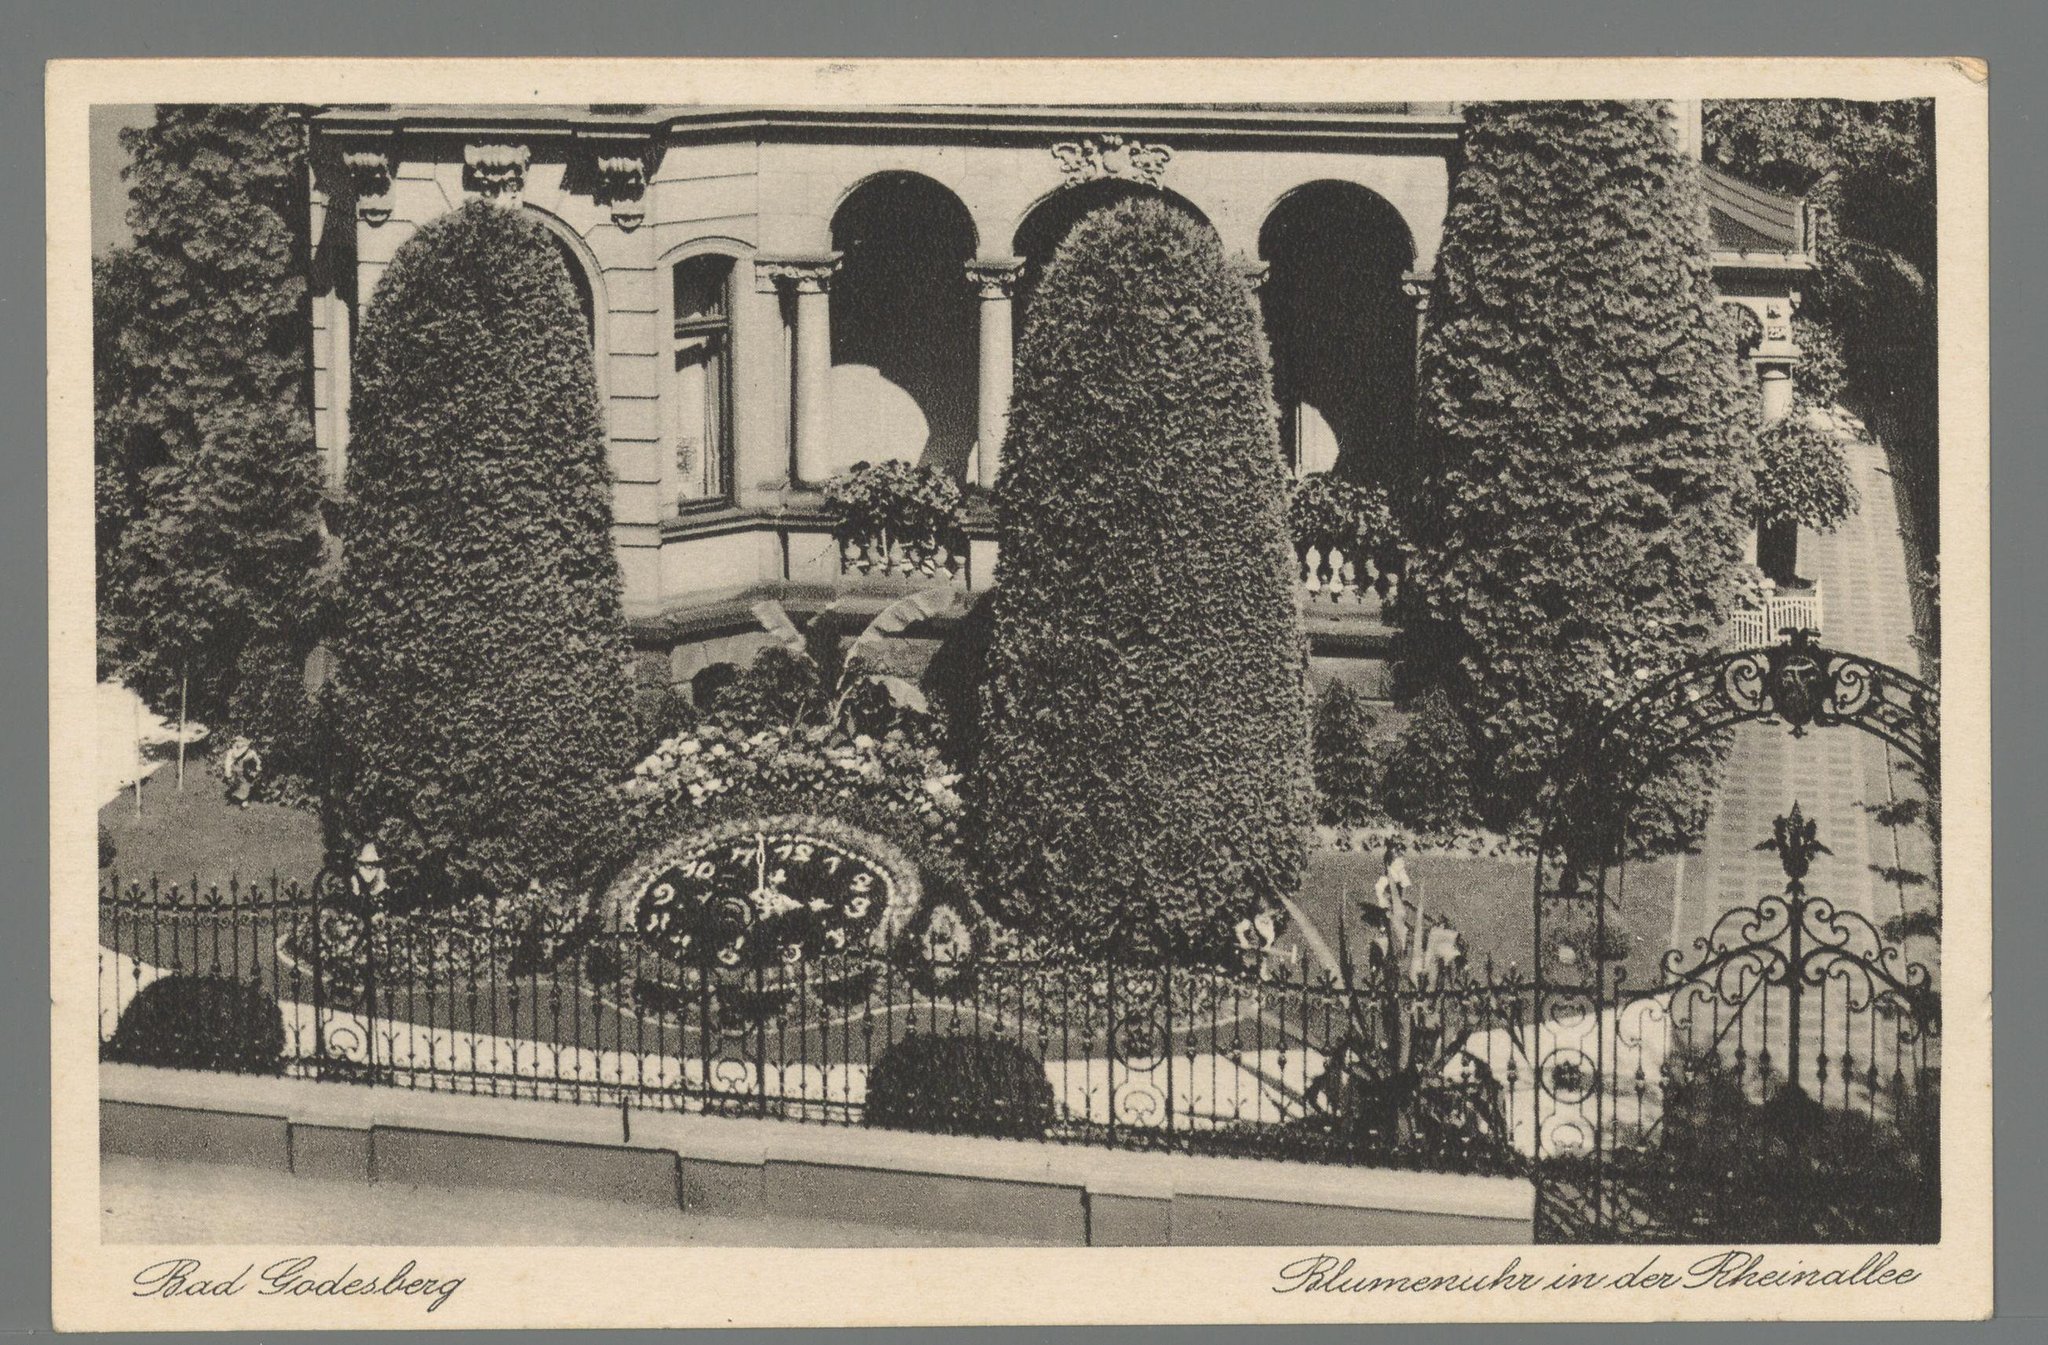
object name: ansichtkaart, prentbriefkaart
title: Bad Godesberg. Blumenuhr in der Rheinallee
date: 1905-1930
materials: cardboard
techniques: photograph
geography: bad godesberg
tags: garden, clock